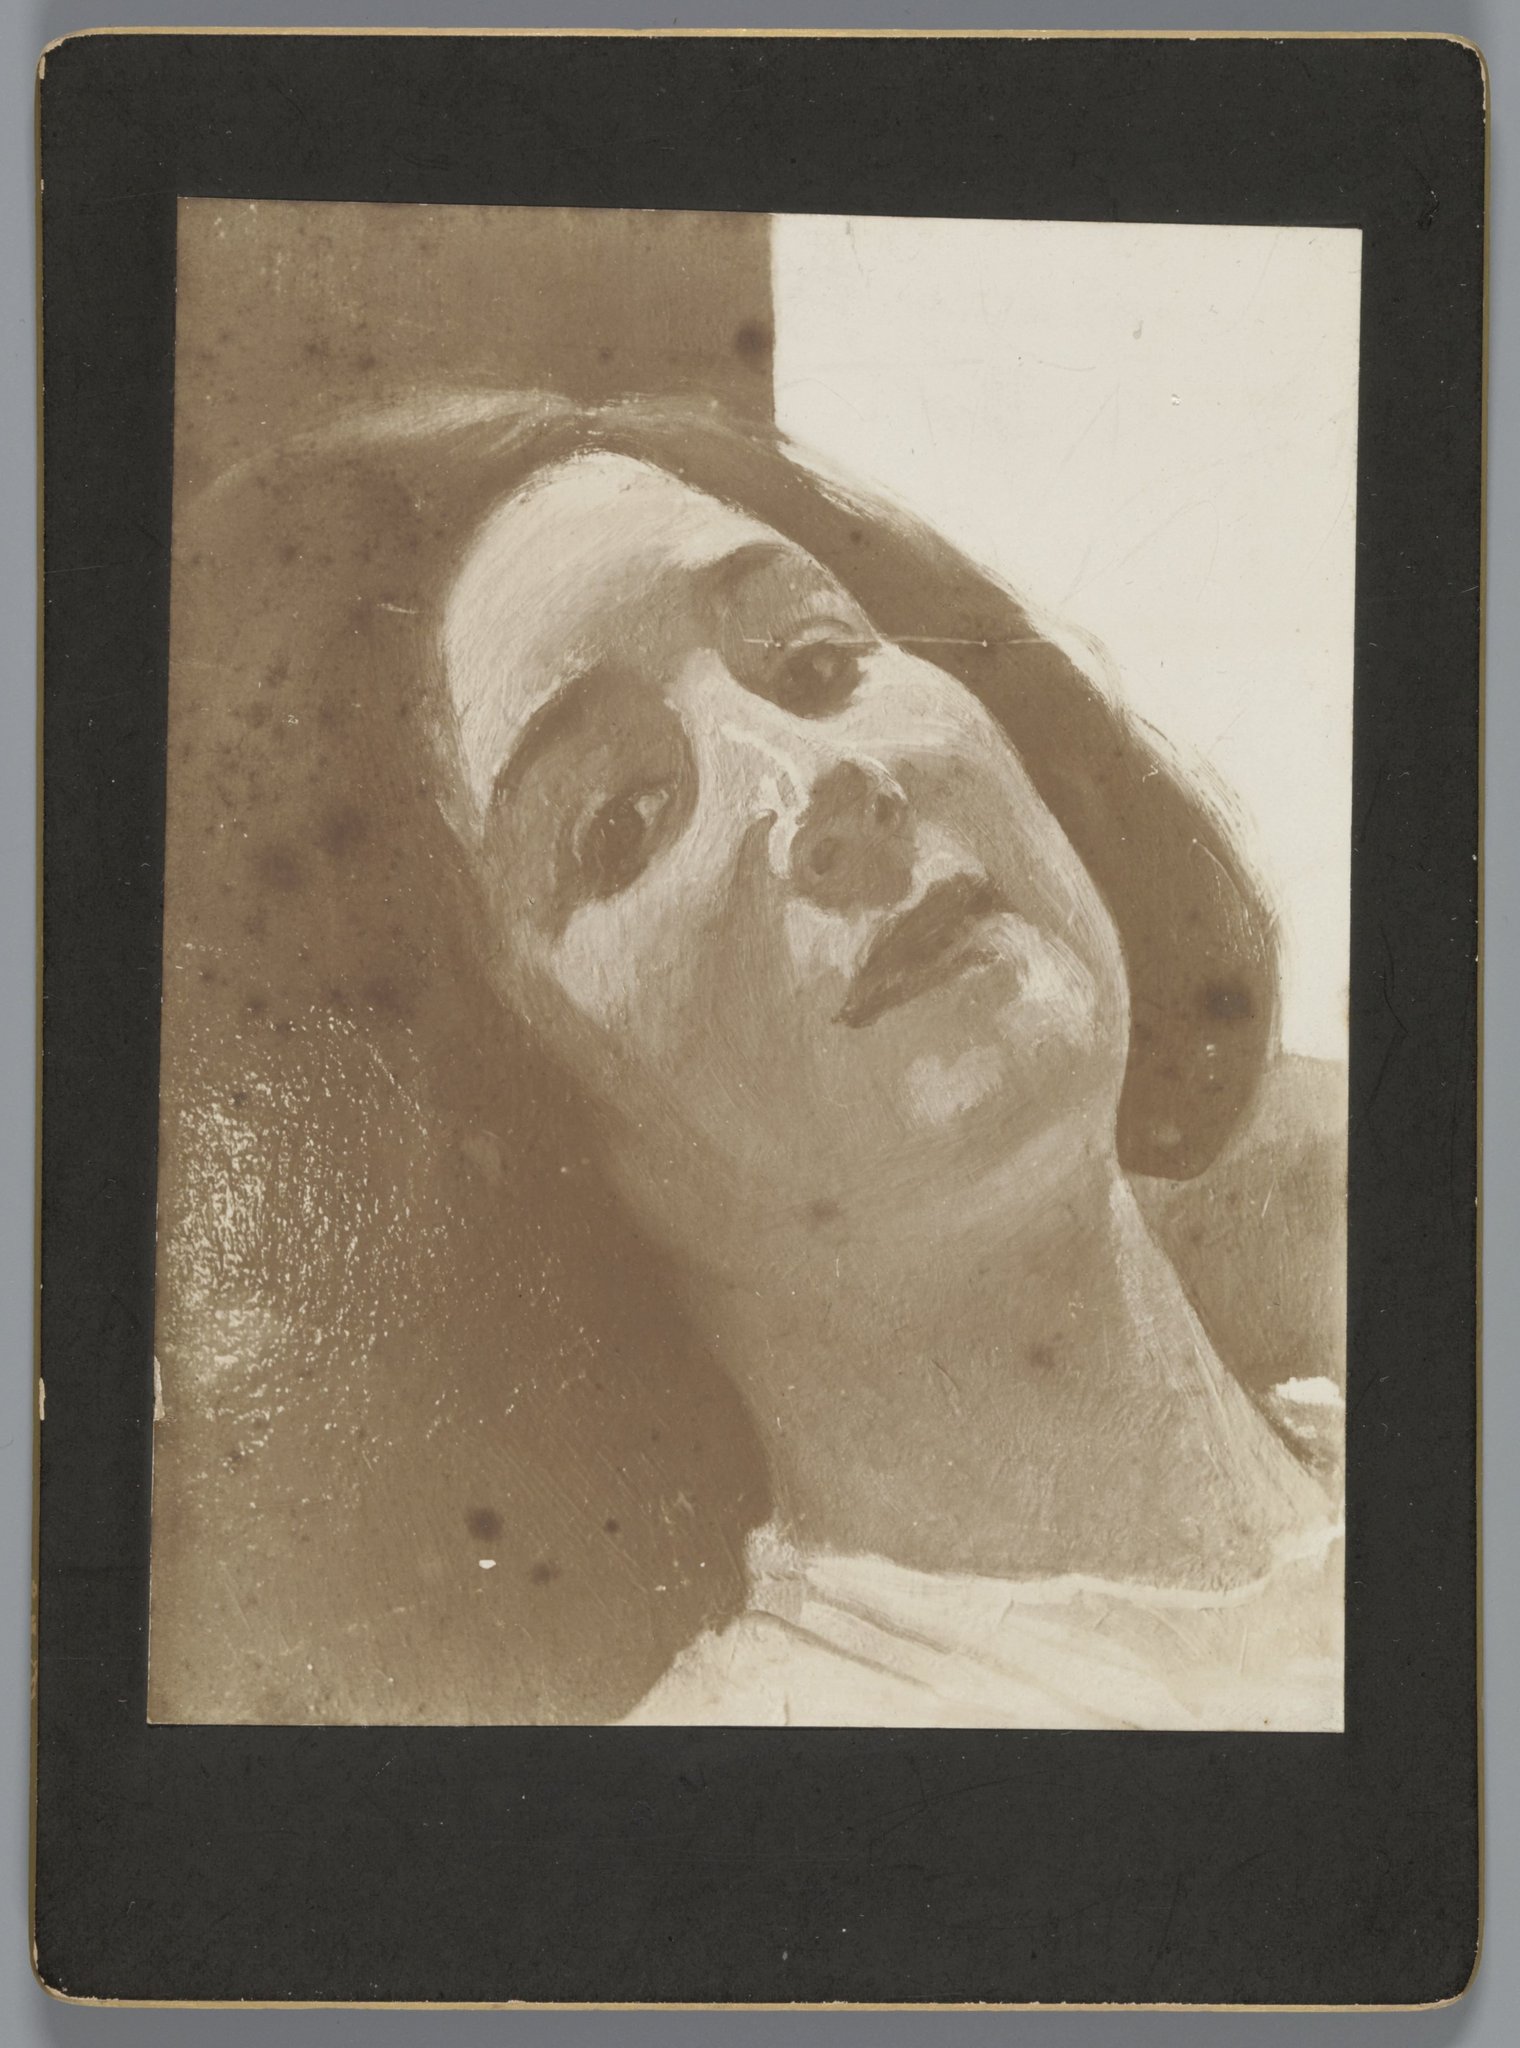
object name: photograph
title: Fotoreproductie van schilderij van Marie Witsen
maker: Anonymous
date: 1860-1915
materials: cardboard, paper, photographic support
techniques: gelatin silver print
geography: netherlands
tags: amsterdam, augusta maria agnes witsen-schorr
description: W296 is het inventarisnummer van het Willem Witsenhuis van het schilderij van Marie Witsen.